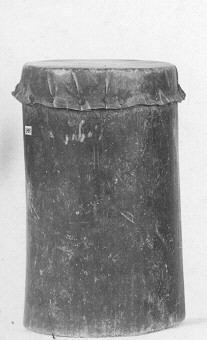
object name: drum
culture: kenyan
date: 1801-1900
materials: wood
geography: kenya